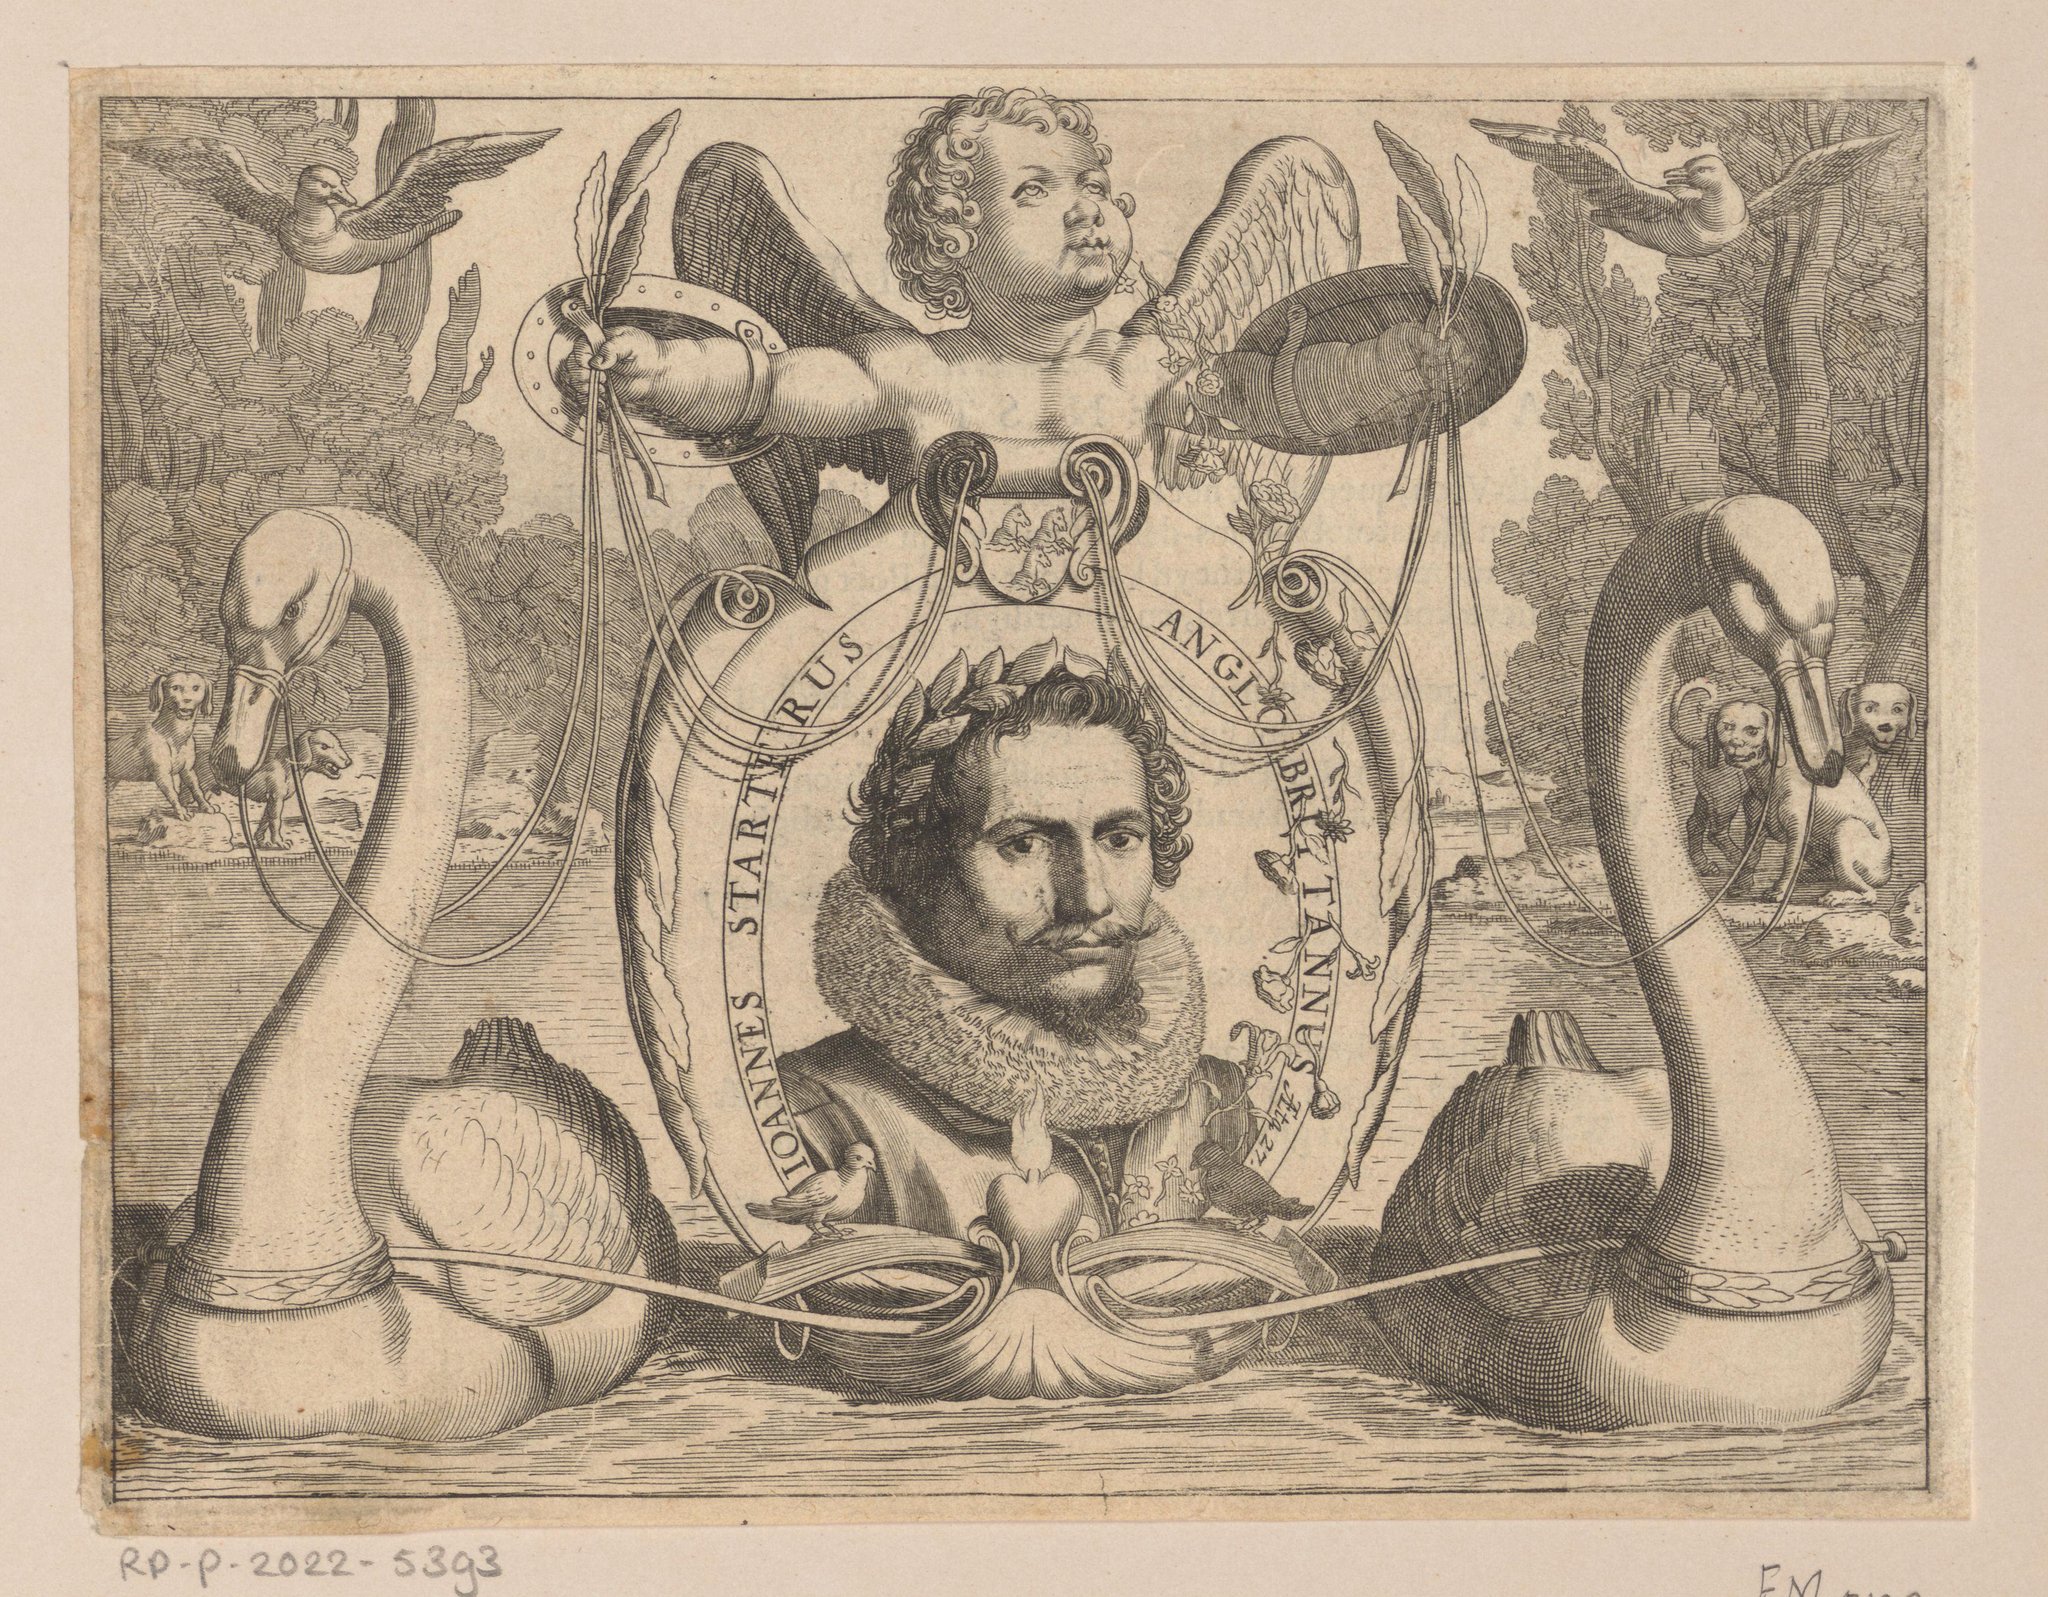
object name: print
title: Portret van Jan Jansz. Starter op 27-jarige leeftijd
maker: Anonymous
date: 1620-1699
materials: paper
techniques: engraving, letterpress printing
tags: london, publisher, jan jansz starter, historical persons, portrait of a writer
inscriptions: inscription: ‘Jan Jansz. Starter (...) 1618 / Losse gelegenheidsgedichten’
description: Met tekst in het Latijn rondom het portret.